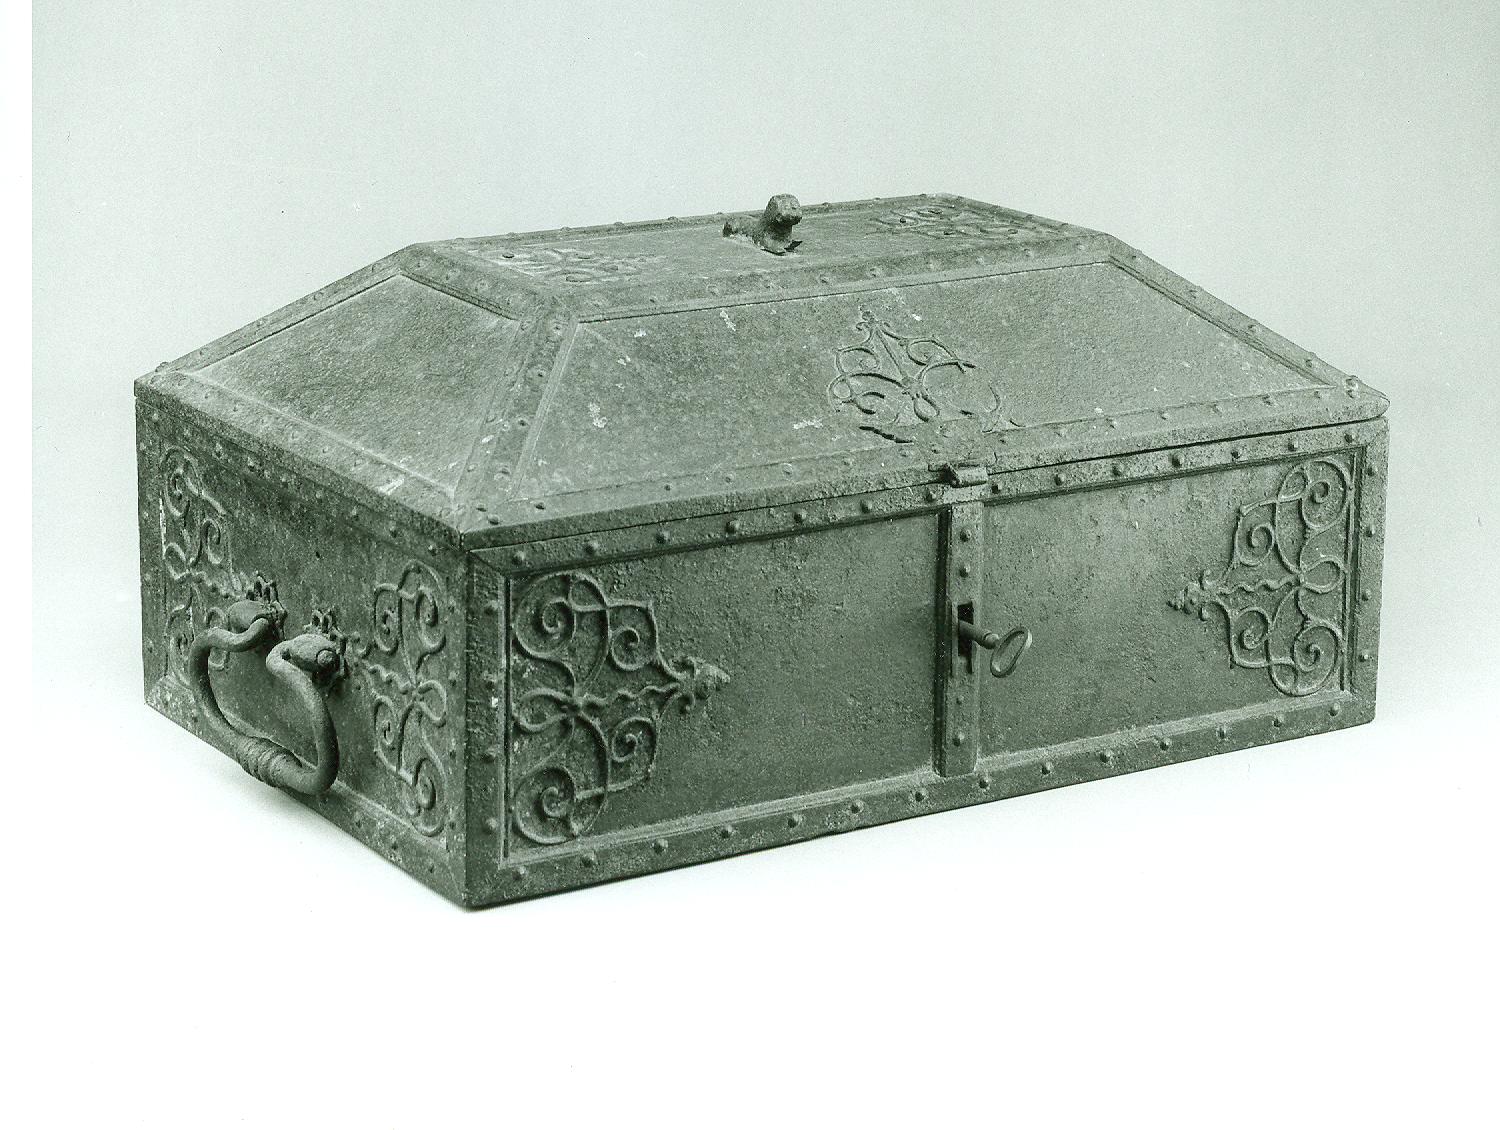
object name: coffer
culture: french or spanish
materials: iron